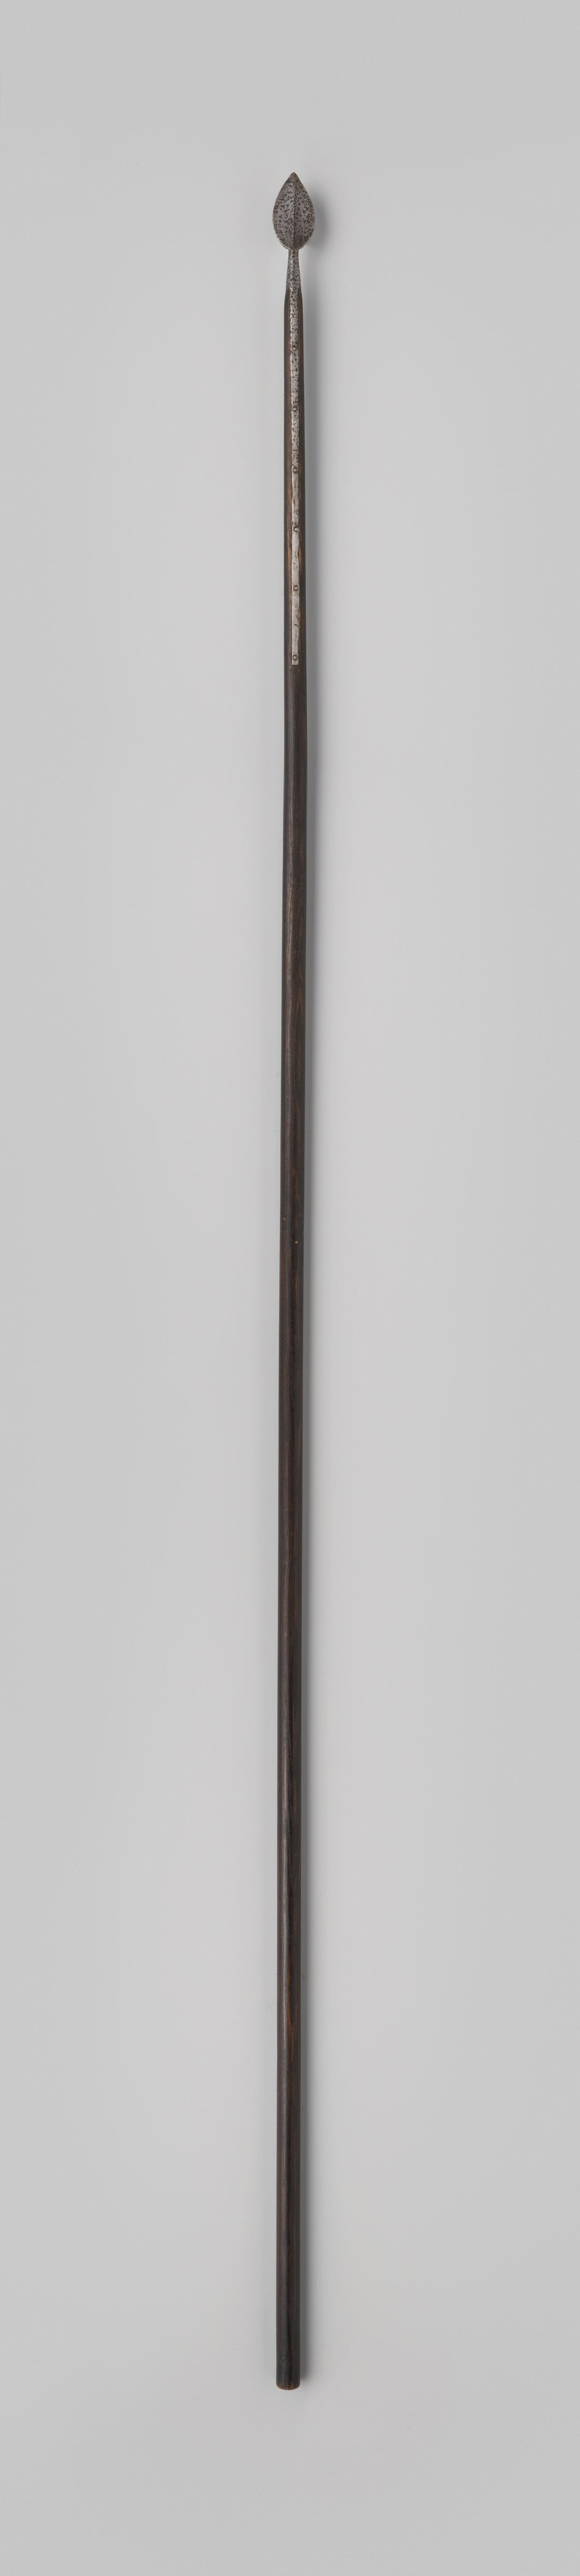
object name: pike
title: Piek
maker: Anonymous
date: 1699-1899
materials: iron, wood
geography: europe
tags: europe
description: Piek met ijzeren hartvormige kling welke aan de stok is vastgeklonken met aan weerzijden zes klinknagels, op de bladen van de kling zitten diverse groeven in het ijzer. De houten stok is zwartgeverfd maar heeft duidelijk nerven over de gehele lengte.